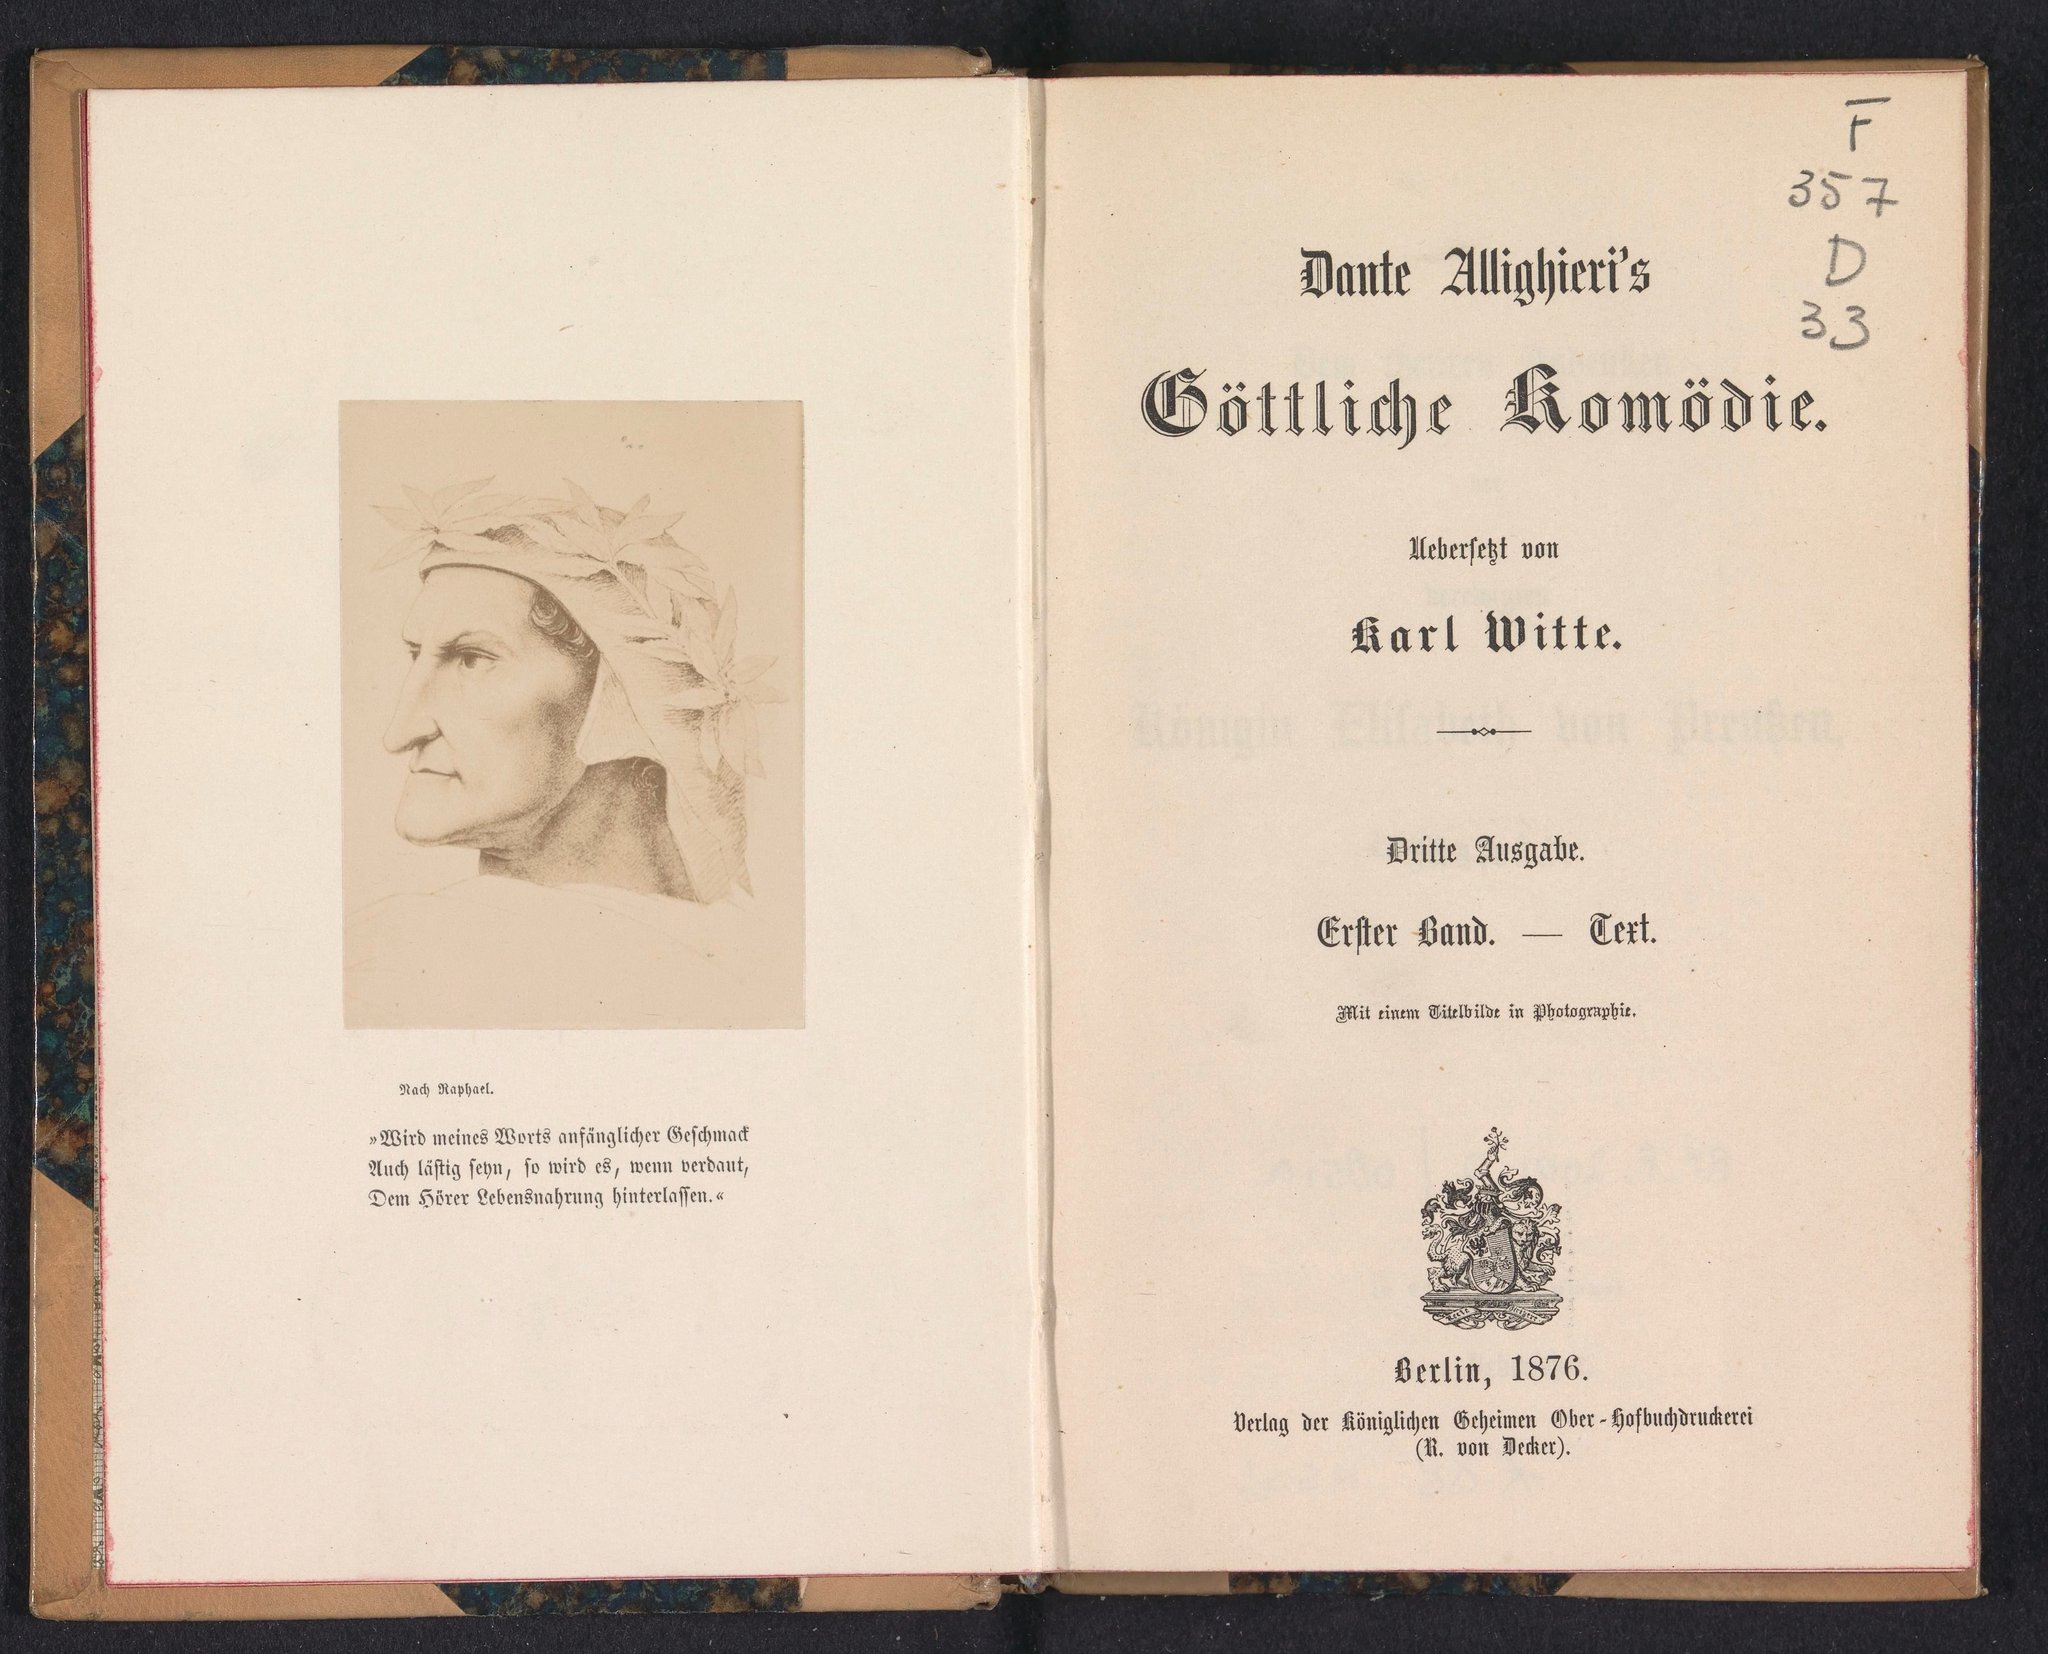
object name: book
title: Dante Allighieri's göttliche Komödie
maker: dante alighieri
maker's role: dichter, filosoof, schrijver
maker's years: 1265-1321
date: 1876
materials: cardboard, leather, paper, photographic support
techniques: marbled paper, albumen print, printing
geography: berlin